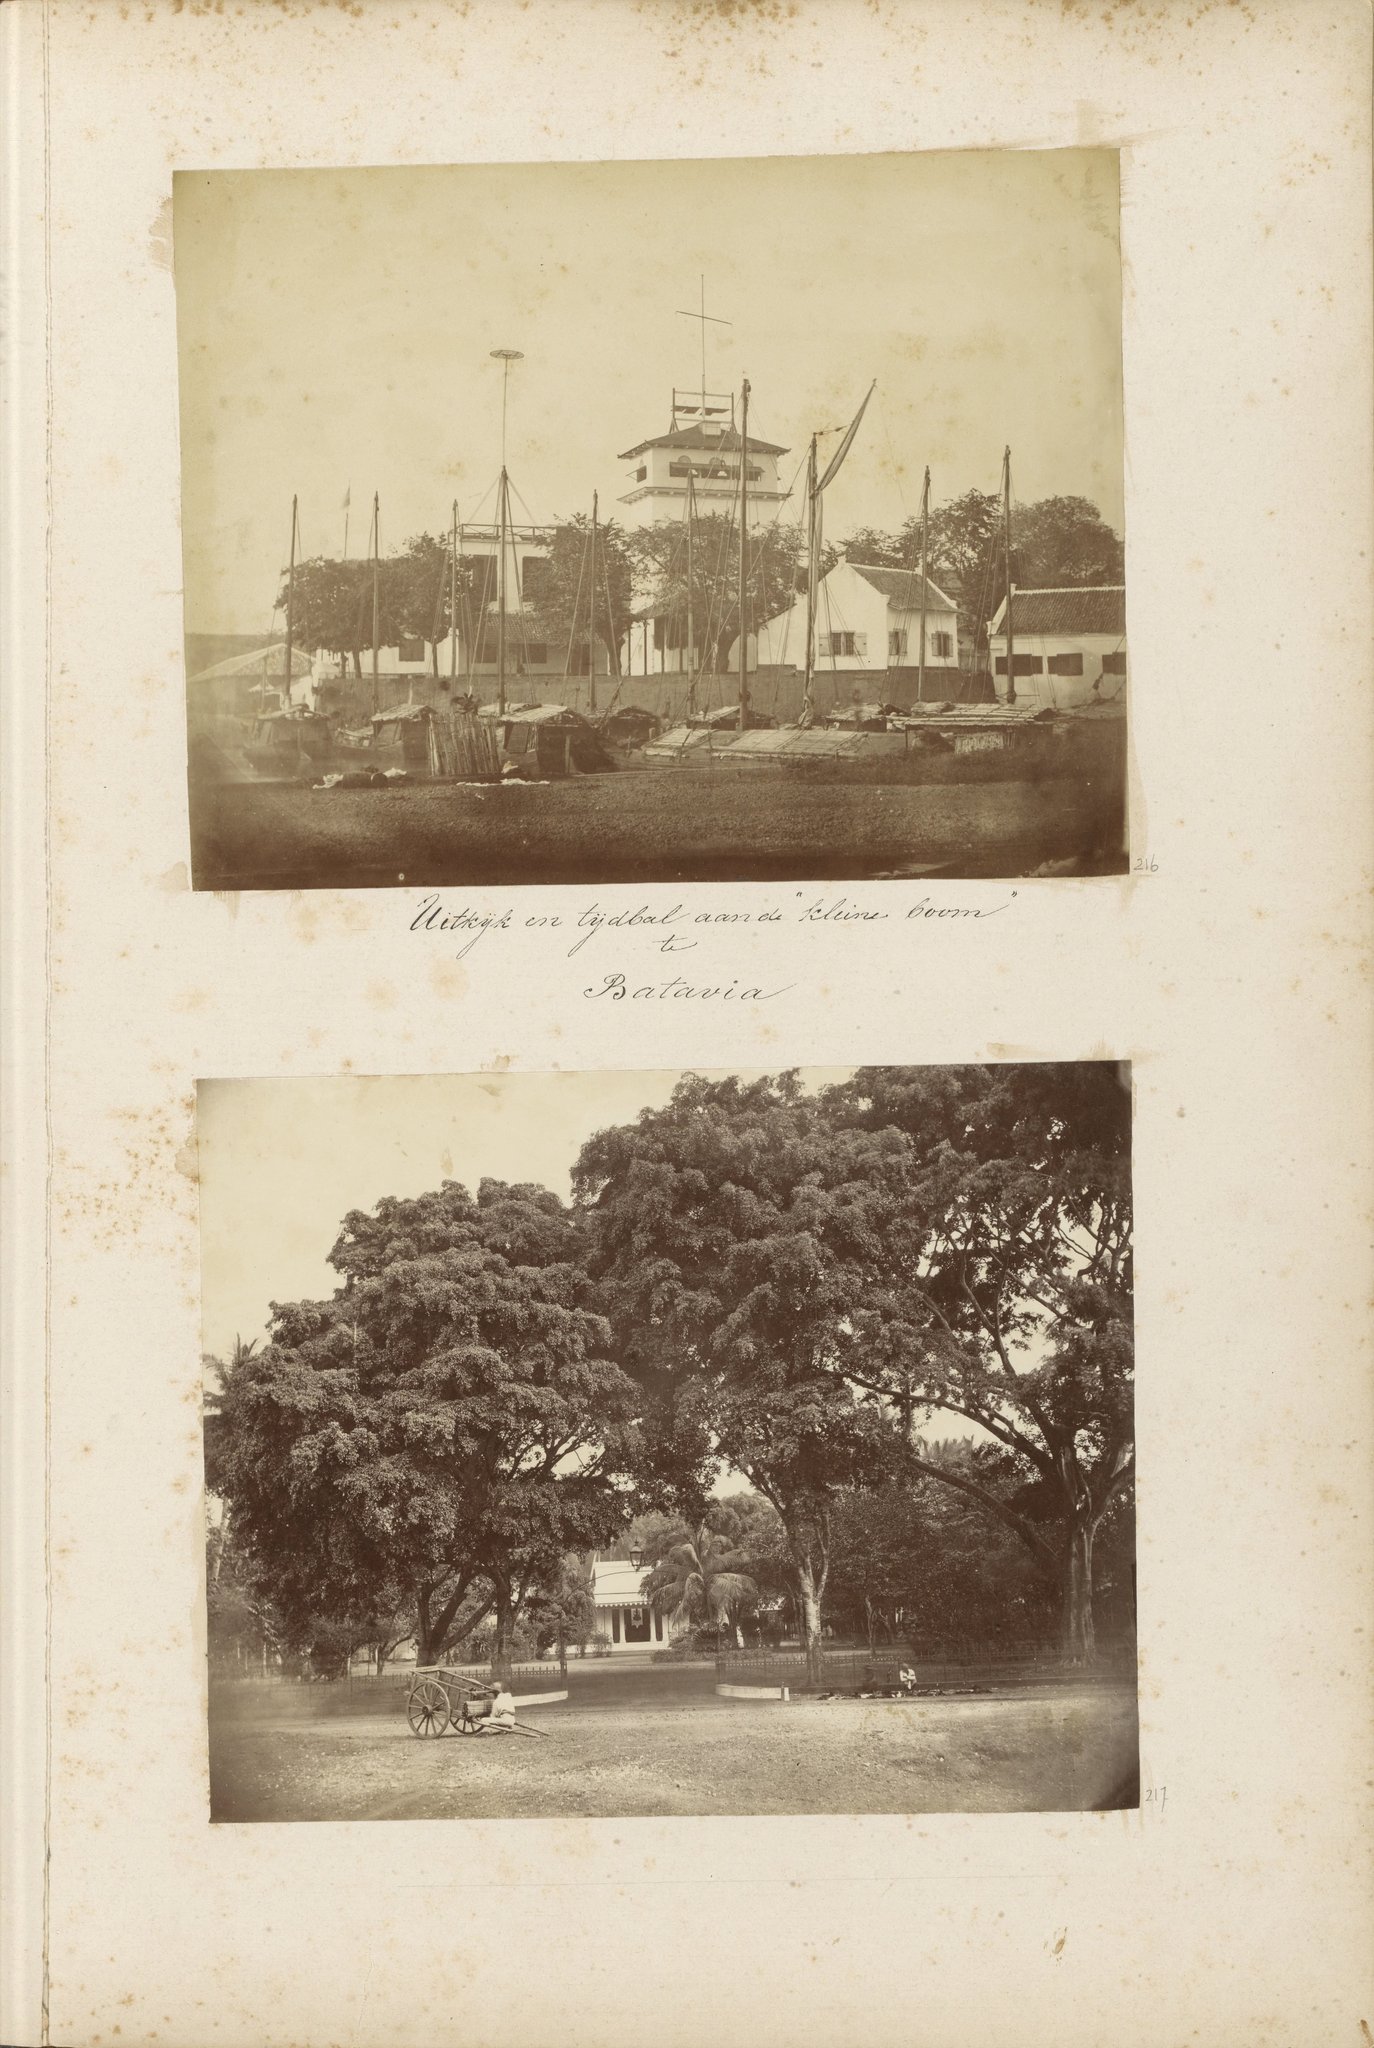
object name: album leaf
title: Ingang naar een villa, vermoedelijk in Batavia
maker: Anonymous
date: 1870-1880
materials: paper, photographic support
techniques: albumen print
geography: batavia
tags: hand-cart, fence, wall, paling, rural housing, e.g. country-house, villa, cottage, gate, entrance, batavia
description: Onderdeel van Fotoalbum van Robert Daniel Crommelin (1841-1907).